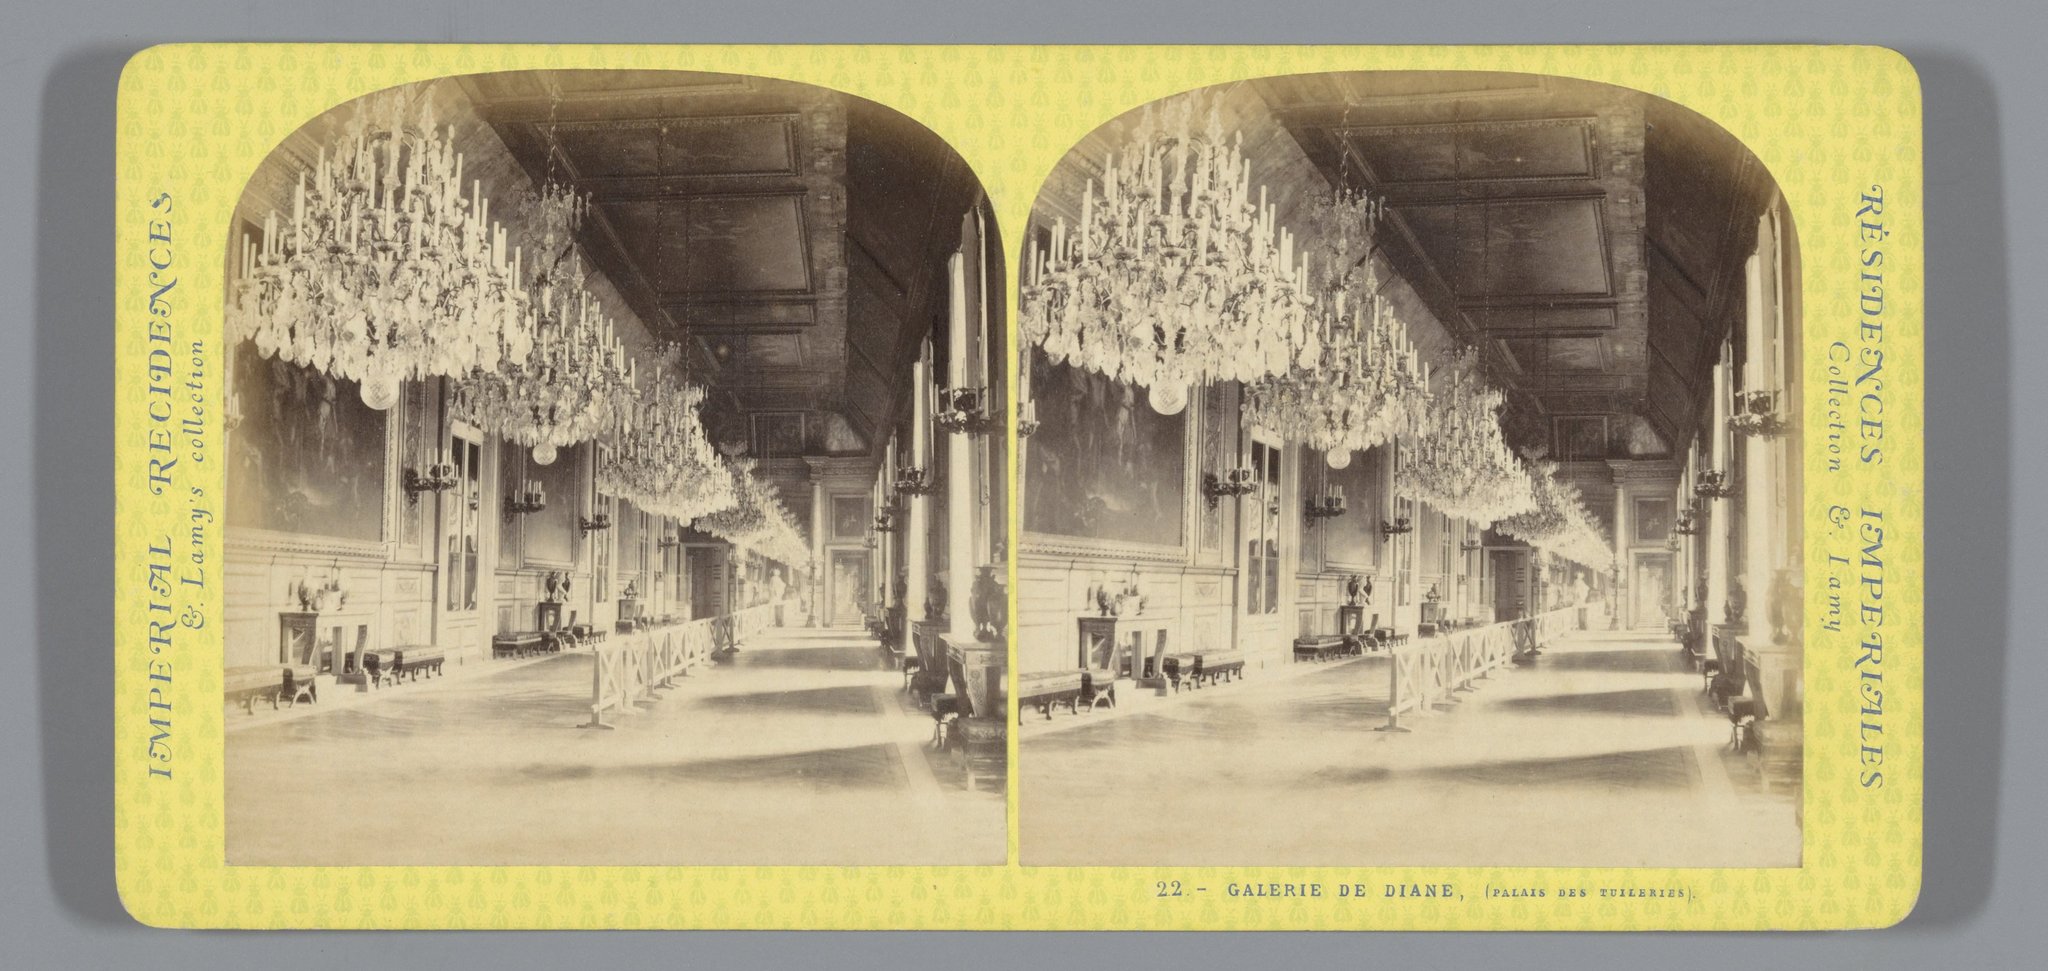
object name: stereograph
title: Galerij van Diana in het Palais des Tuileries te Parijs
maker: ernest eléonor pierre lamy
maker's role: publisher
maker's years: 1828-1900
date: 1860-1880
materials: cardboard, photographic support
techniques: albumen print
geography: tuileries palace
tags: palace, gallery (spacious corridor), interior ~ representation of a building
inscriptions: number: ‘22.’, inscription: ‘E. Lamy's collection’